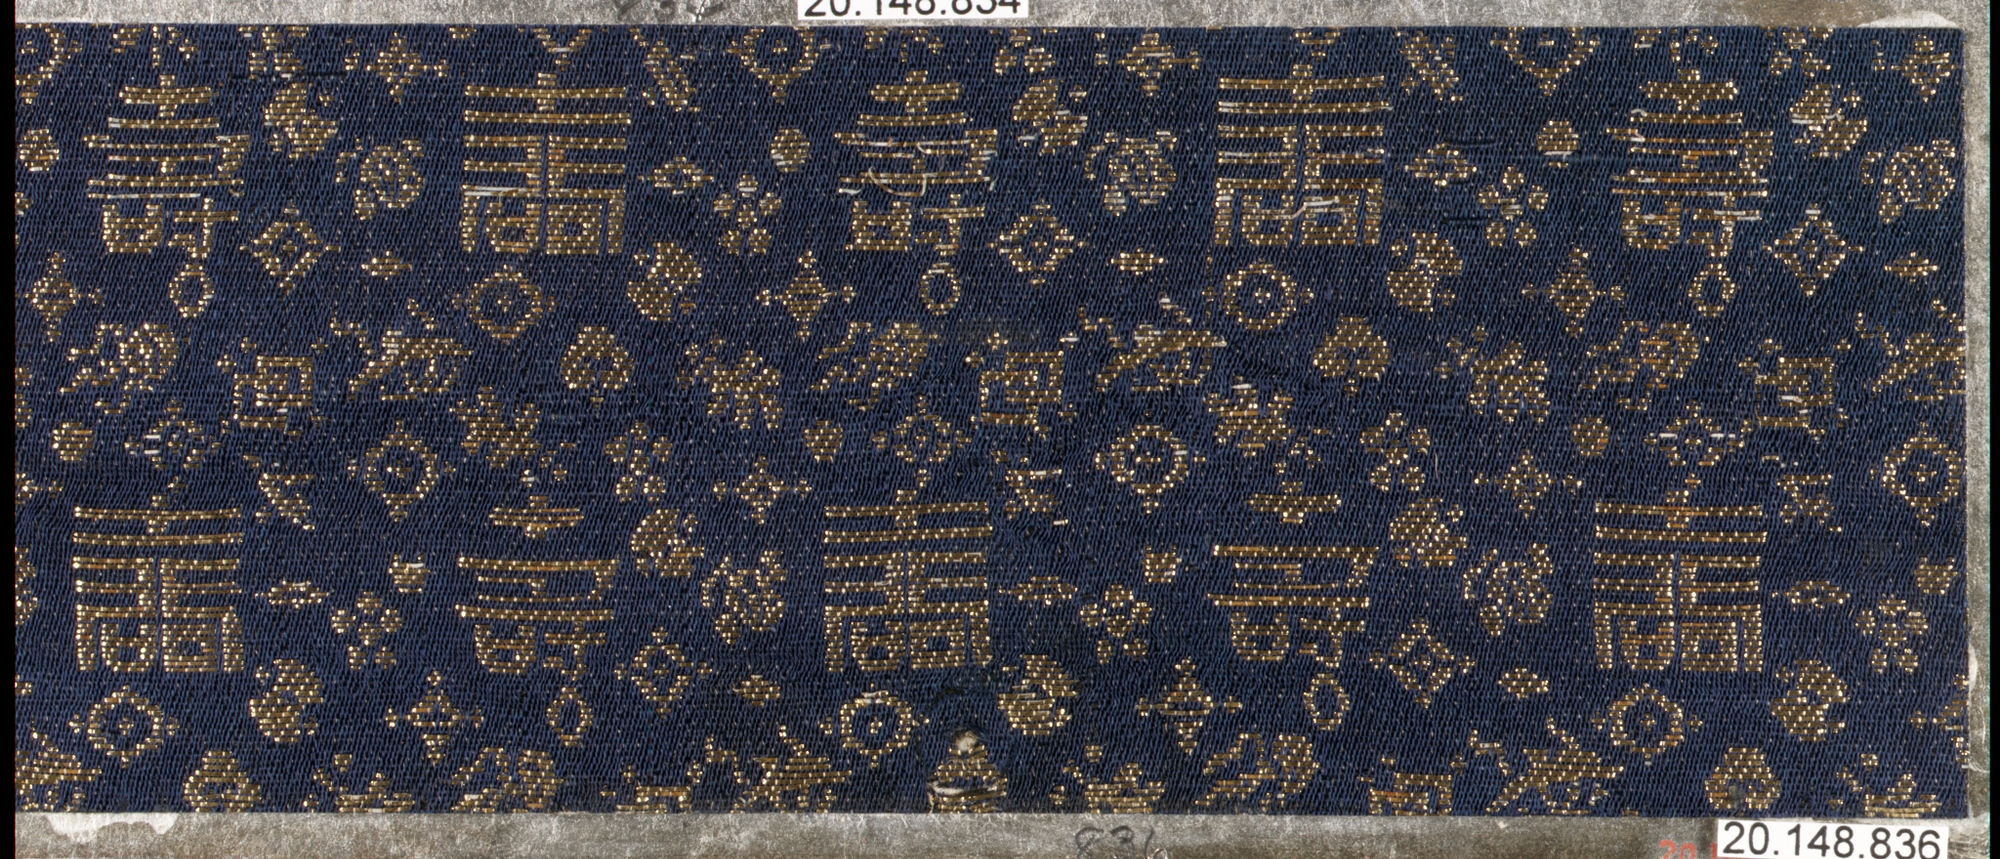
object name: piece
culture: japanese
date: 1701-1800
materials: silk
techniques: compound weave